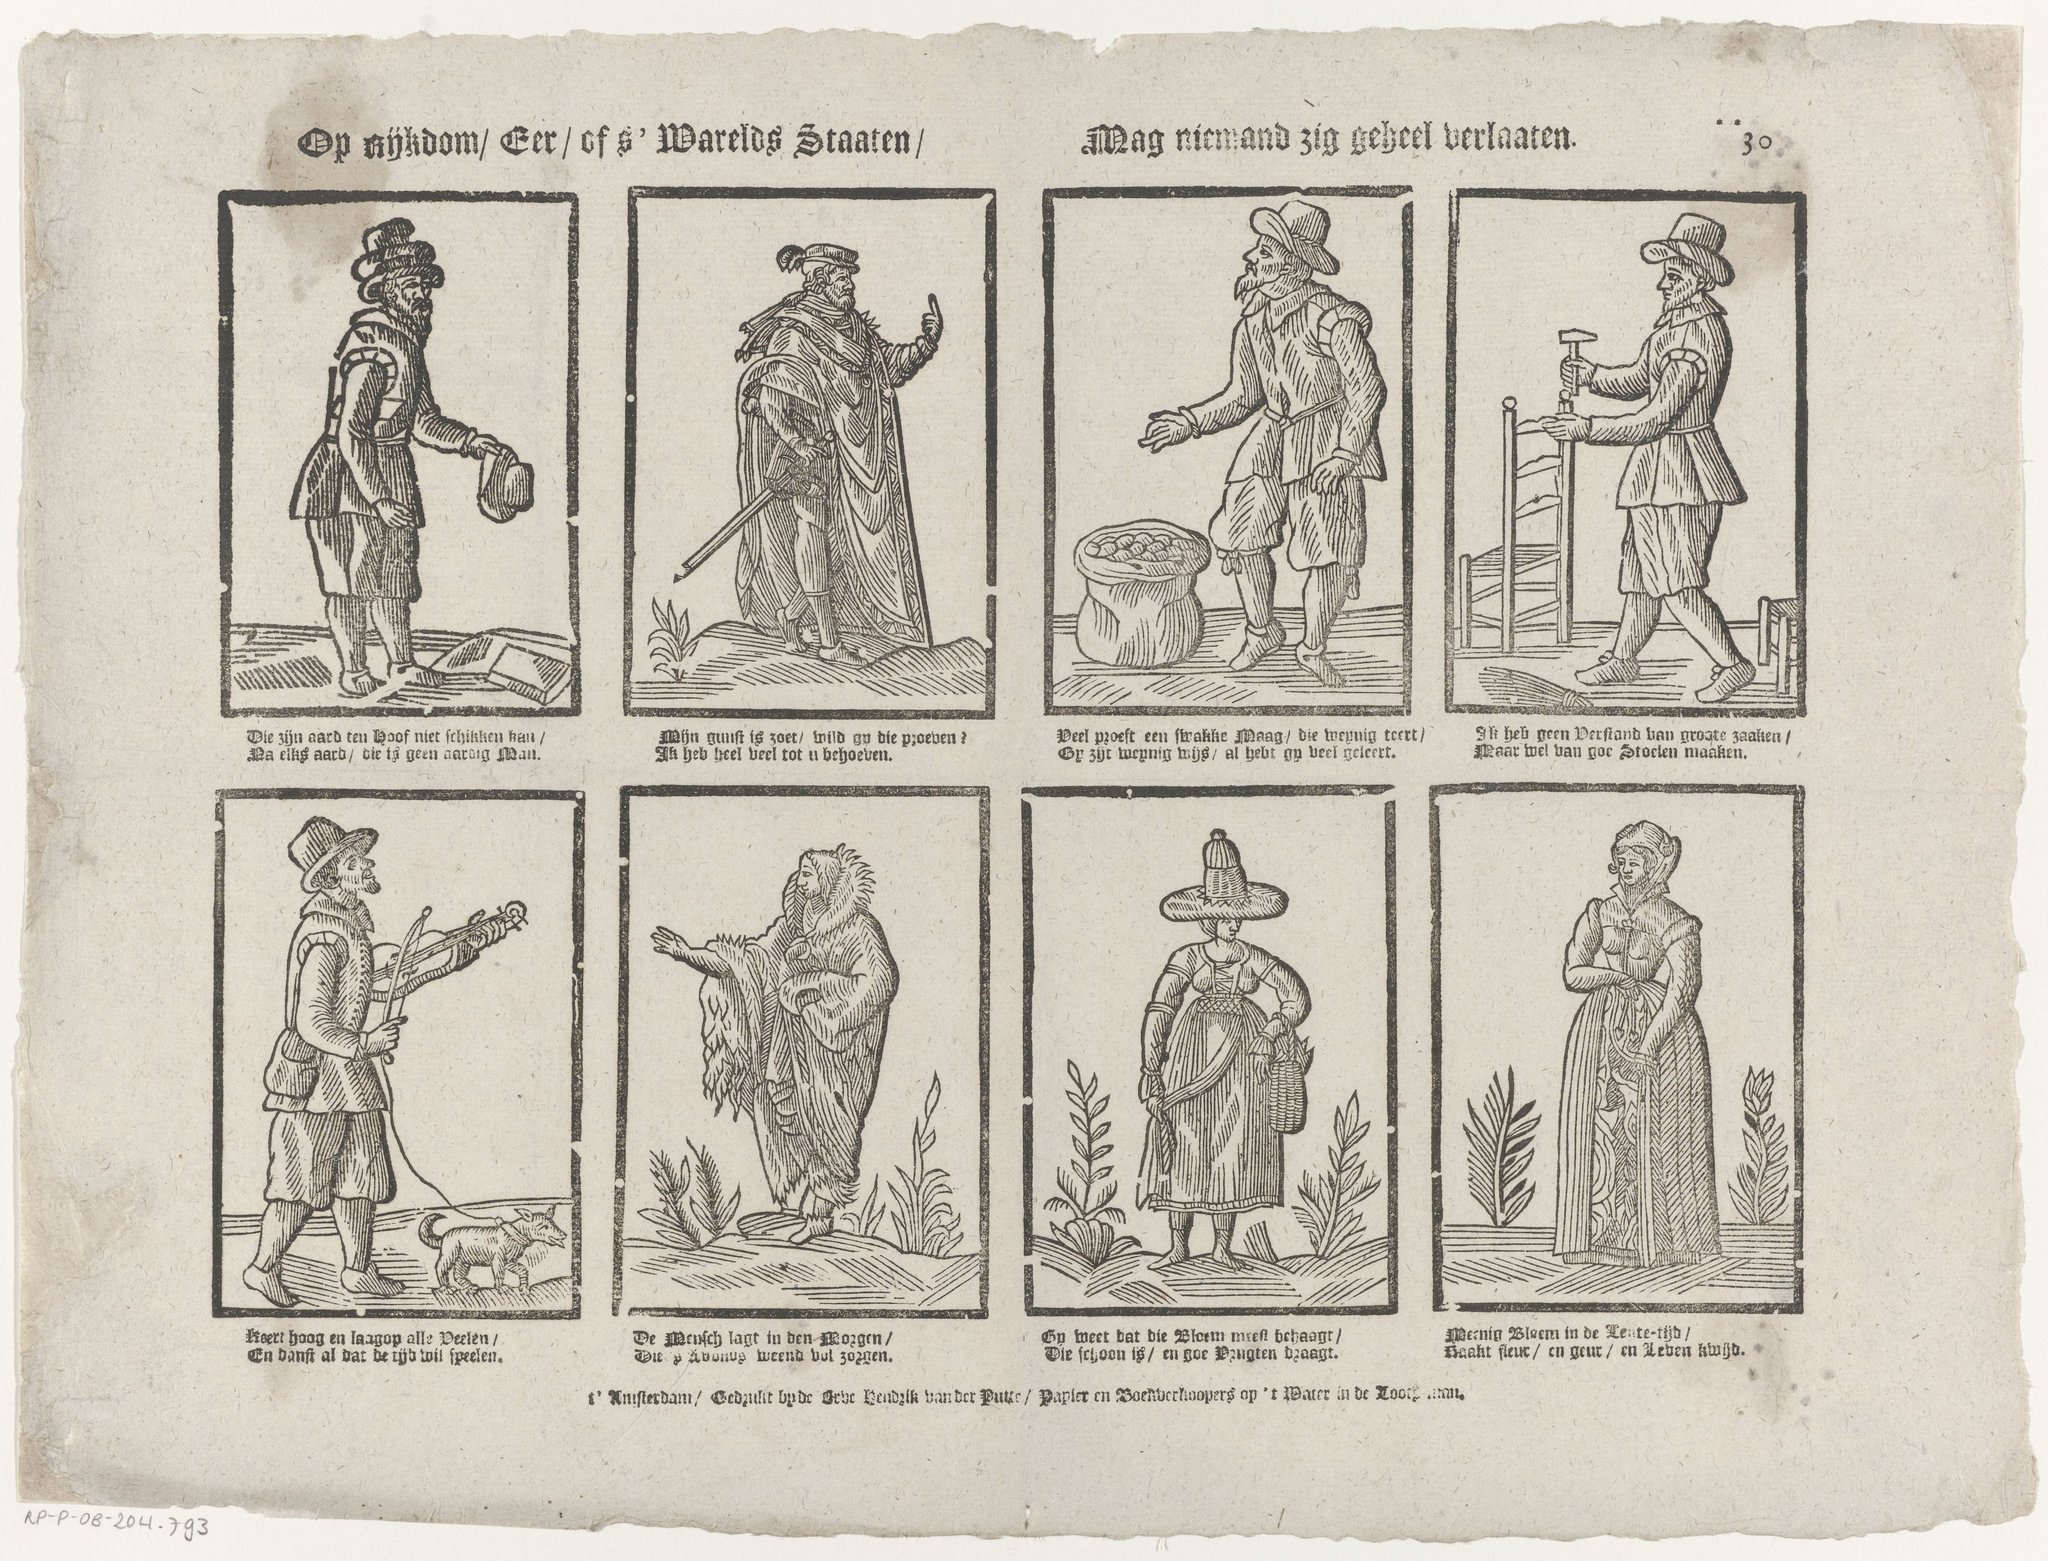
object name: popular print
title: Op rijkdom / eer / of 's warelds staaten / Mag niemand zig geheel verlaaten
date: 1767-1793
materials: paper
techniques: letterpress printing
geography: amsterdam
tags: musician at work, human types, street-trader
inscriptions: collector's mark: Lugt 2760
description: Blad met 8 voorstellingen van verschillende figuren, waaronder een stoelenmaker en een violist. Onder elke afbeelding een tweeregelig vers. Genummerd rechtsboven: **30.